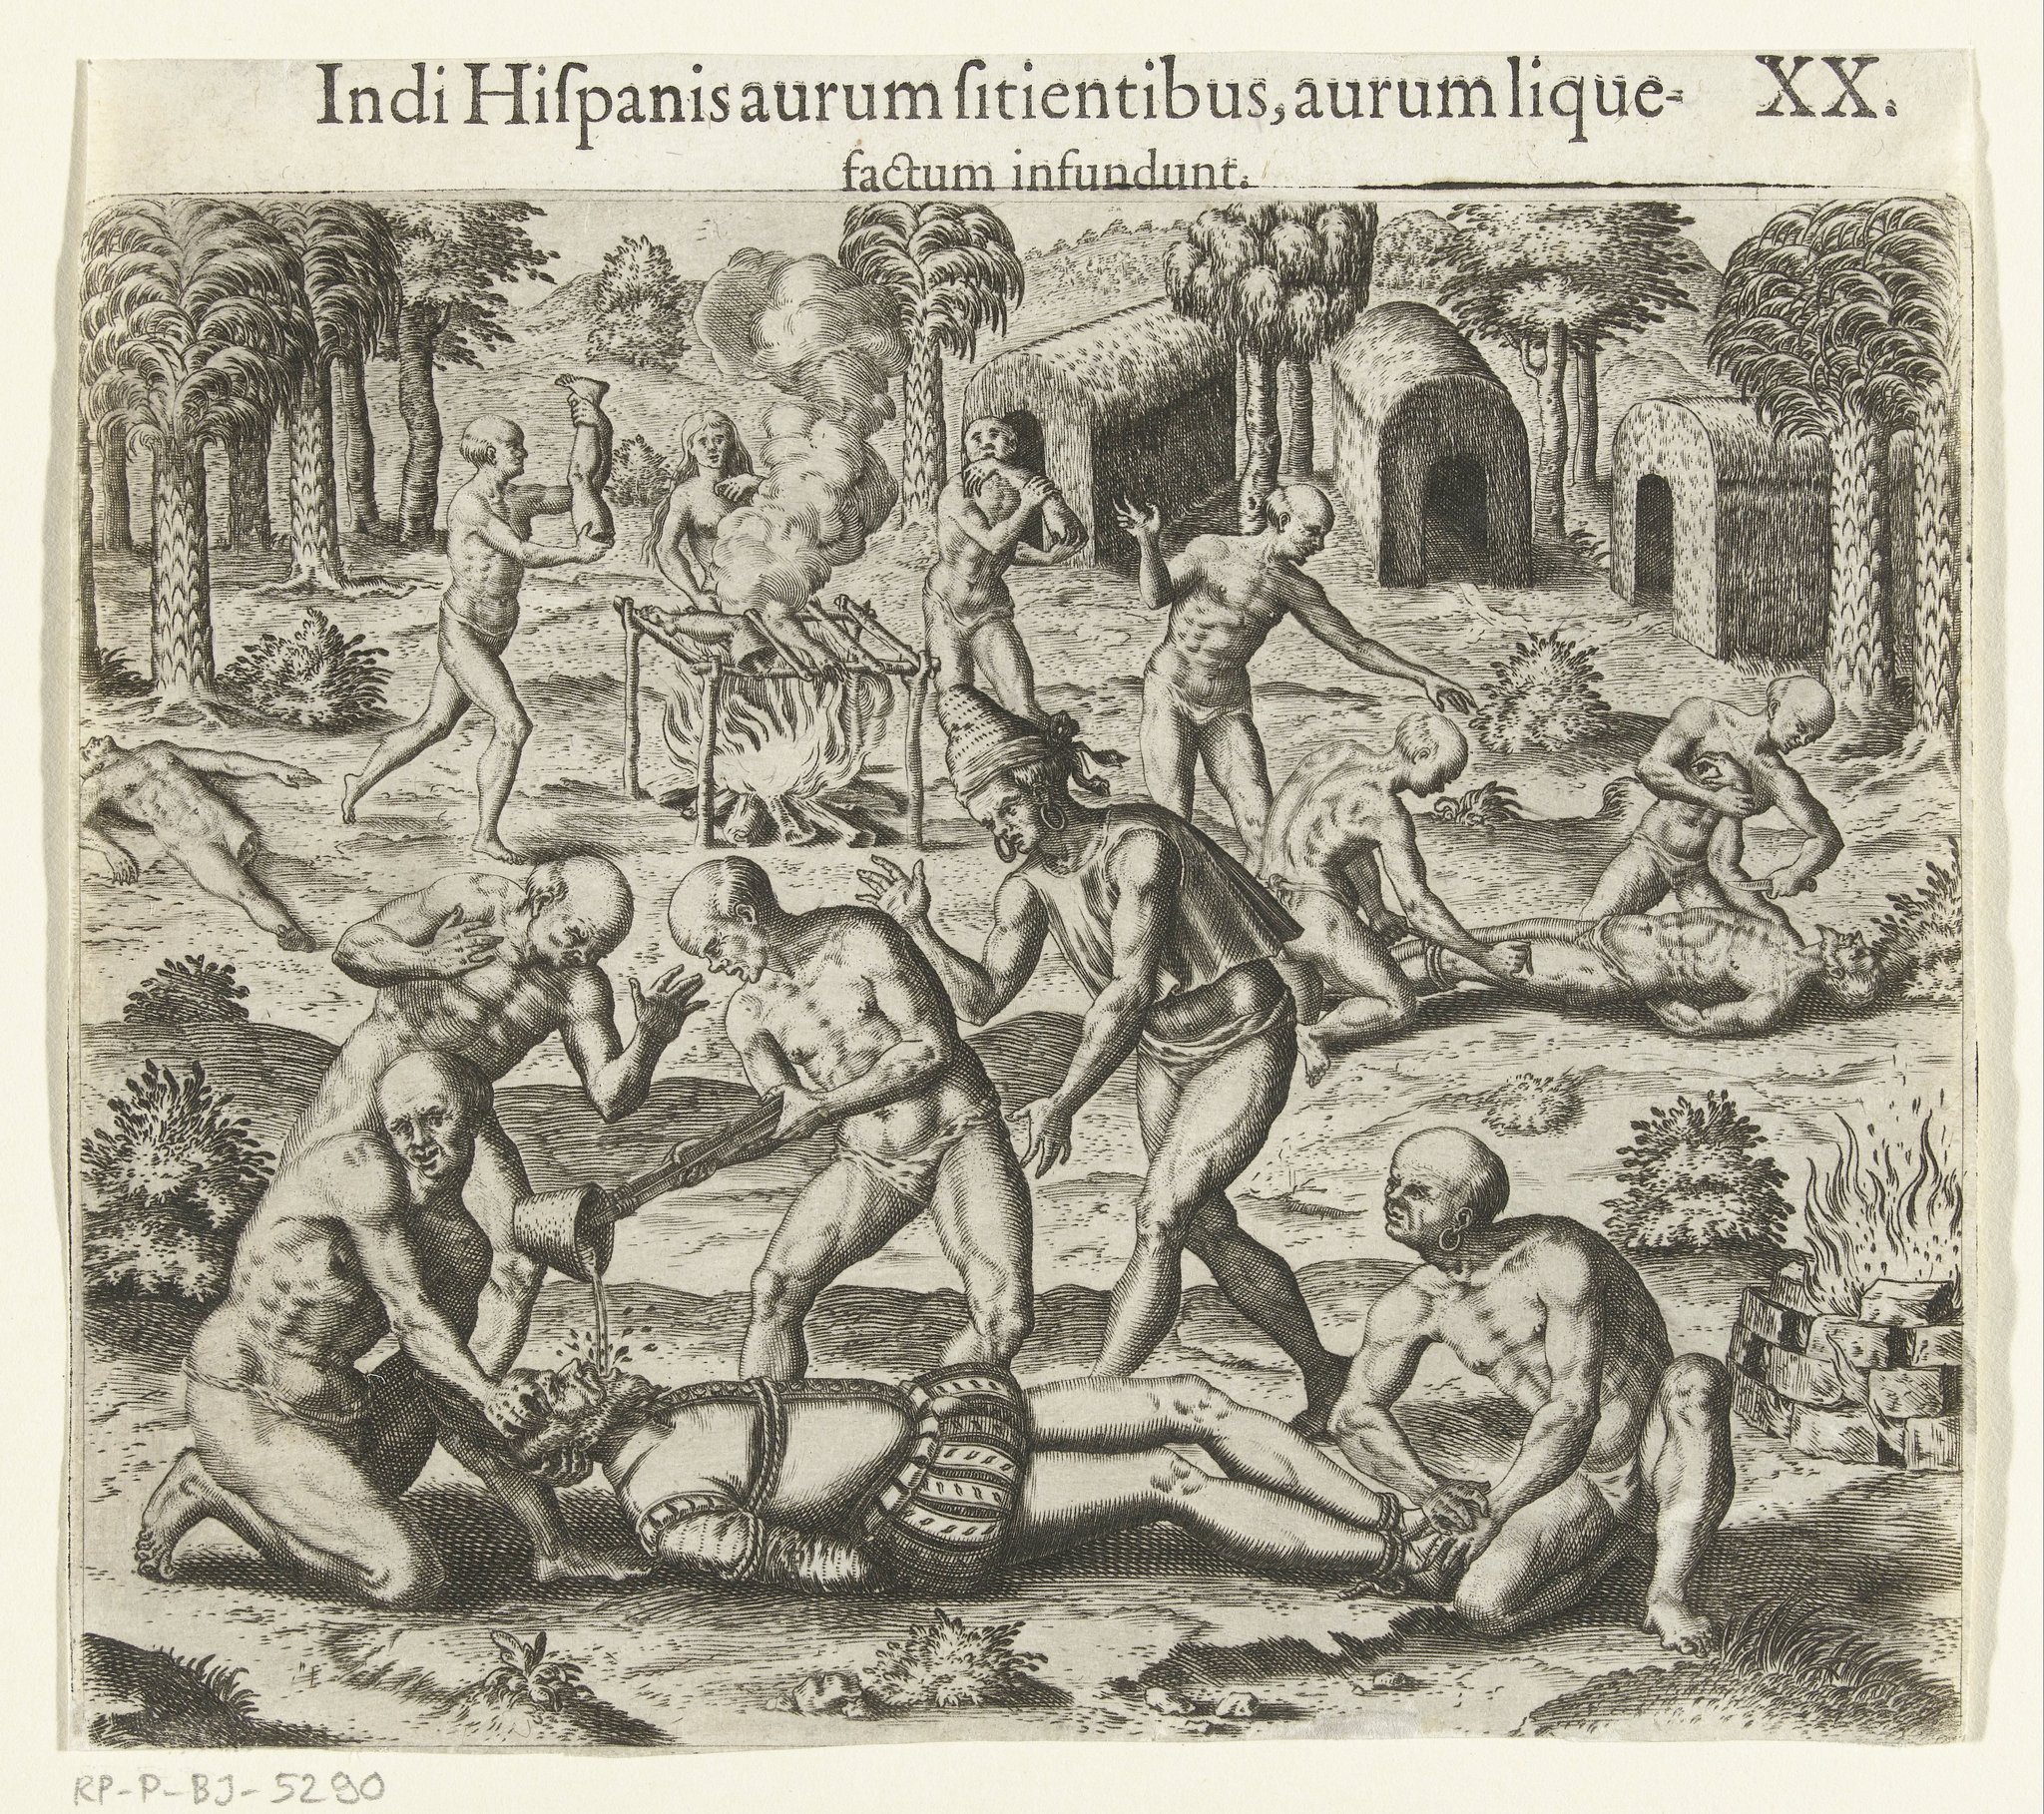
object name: print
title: Indianen gieten vloeibaar goud in de mond van een Spanjaard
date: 1594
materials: paper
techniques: engraving, letterpress printing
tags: cannibalism ~ non-christian religions, roasting, grilling, torture, native peoples of the americas, cannibalism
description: Een groepje Indianen houdt een Spanjaard gevangen. Een man houdt een steelpannetje vast en giet vloeibaar goud in de mond van de gevangene. Op de achtergrond zijn anderen bezig om het lichaam van een dode Europeaan in stukken te snijden en zijn ledematen op het vuur te roosteren. Een man bijt gretig in een arm.